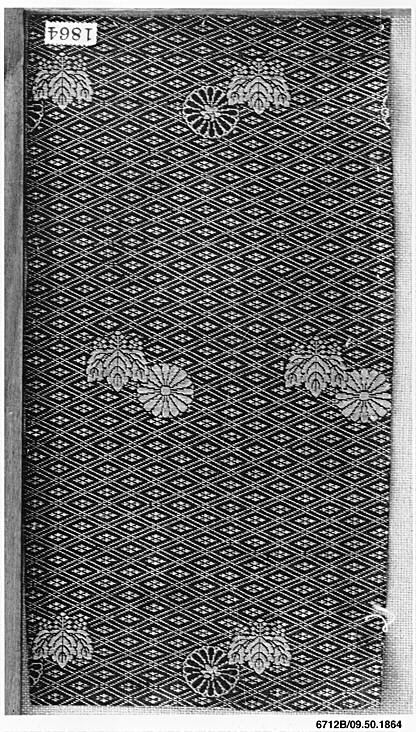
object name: piece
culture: japanese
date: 1801-1900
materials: silk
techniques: brocade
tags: leaves